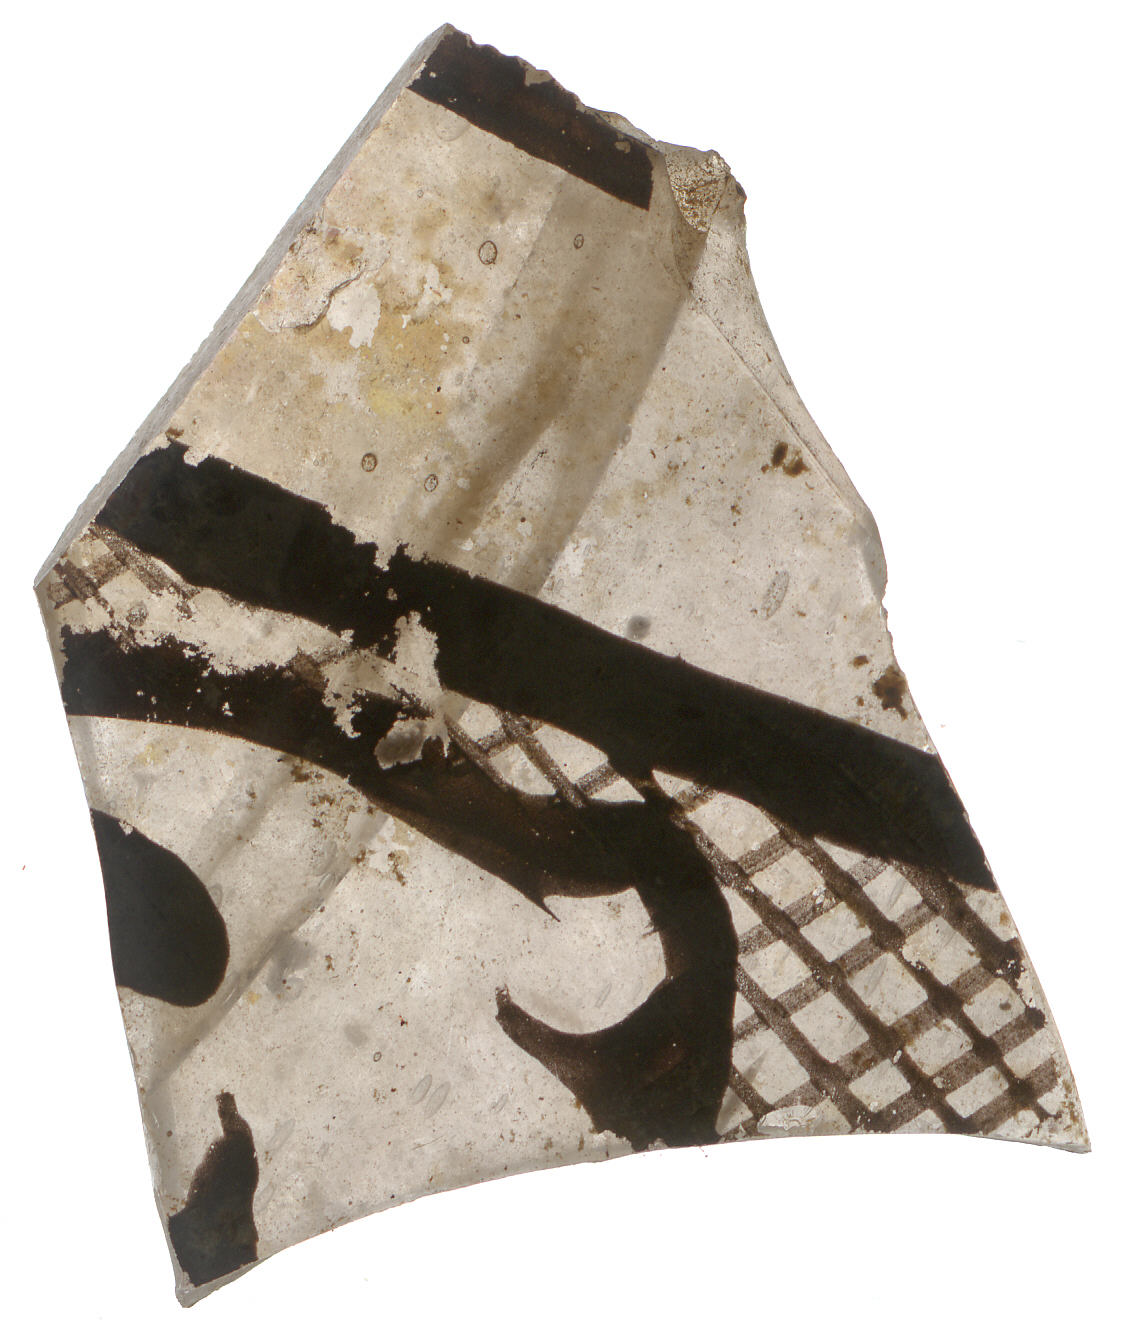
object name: fragment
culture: crusader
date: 1201-1300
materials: glass